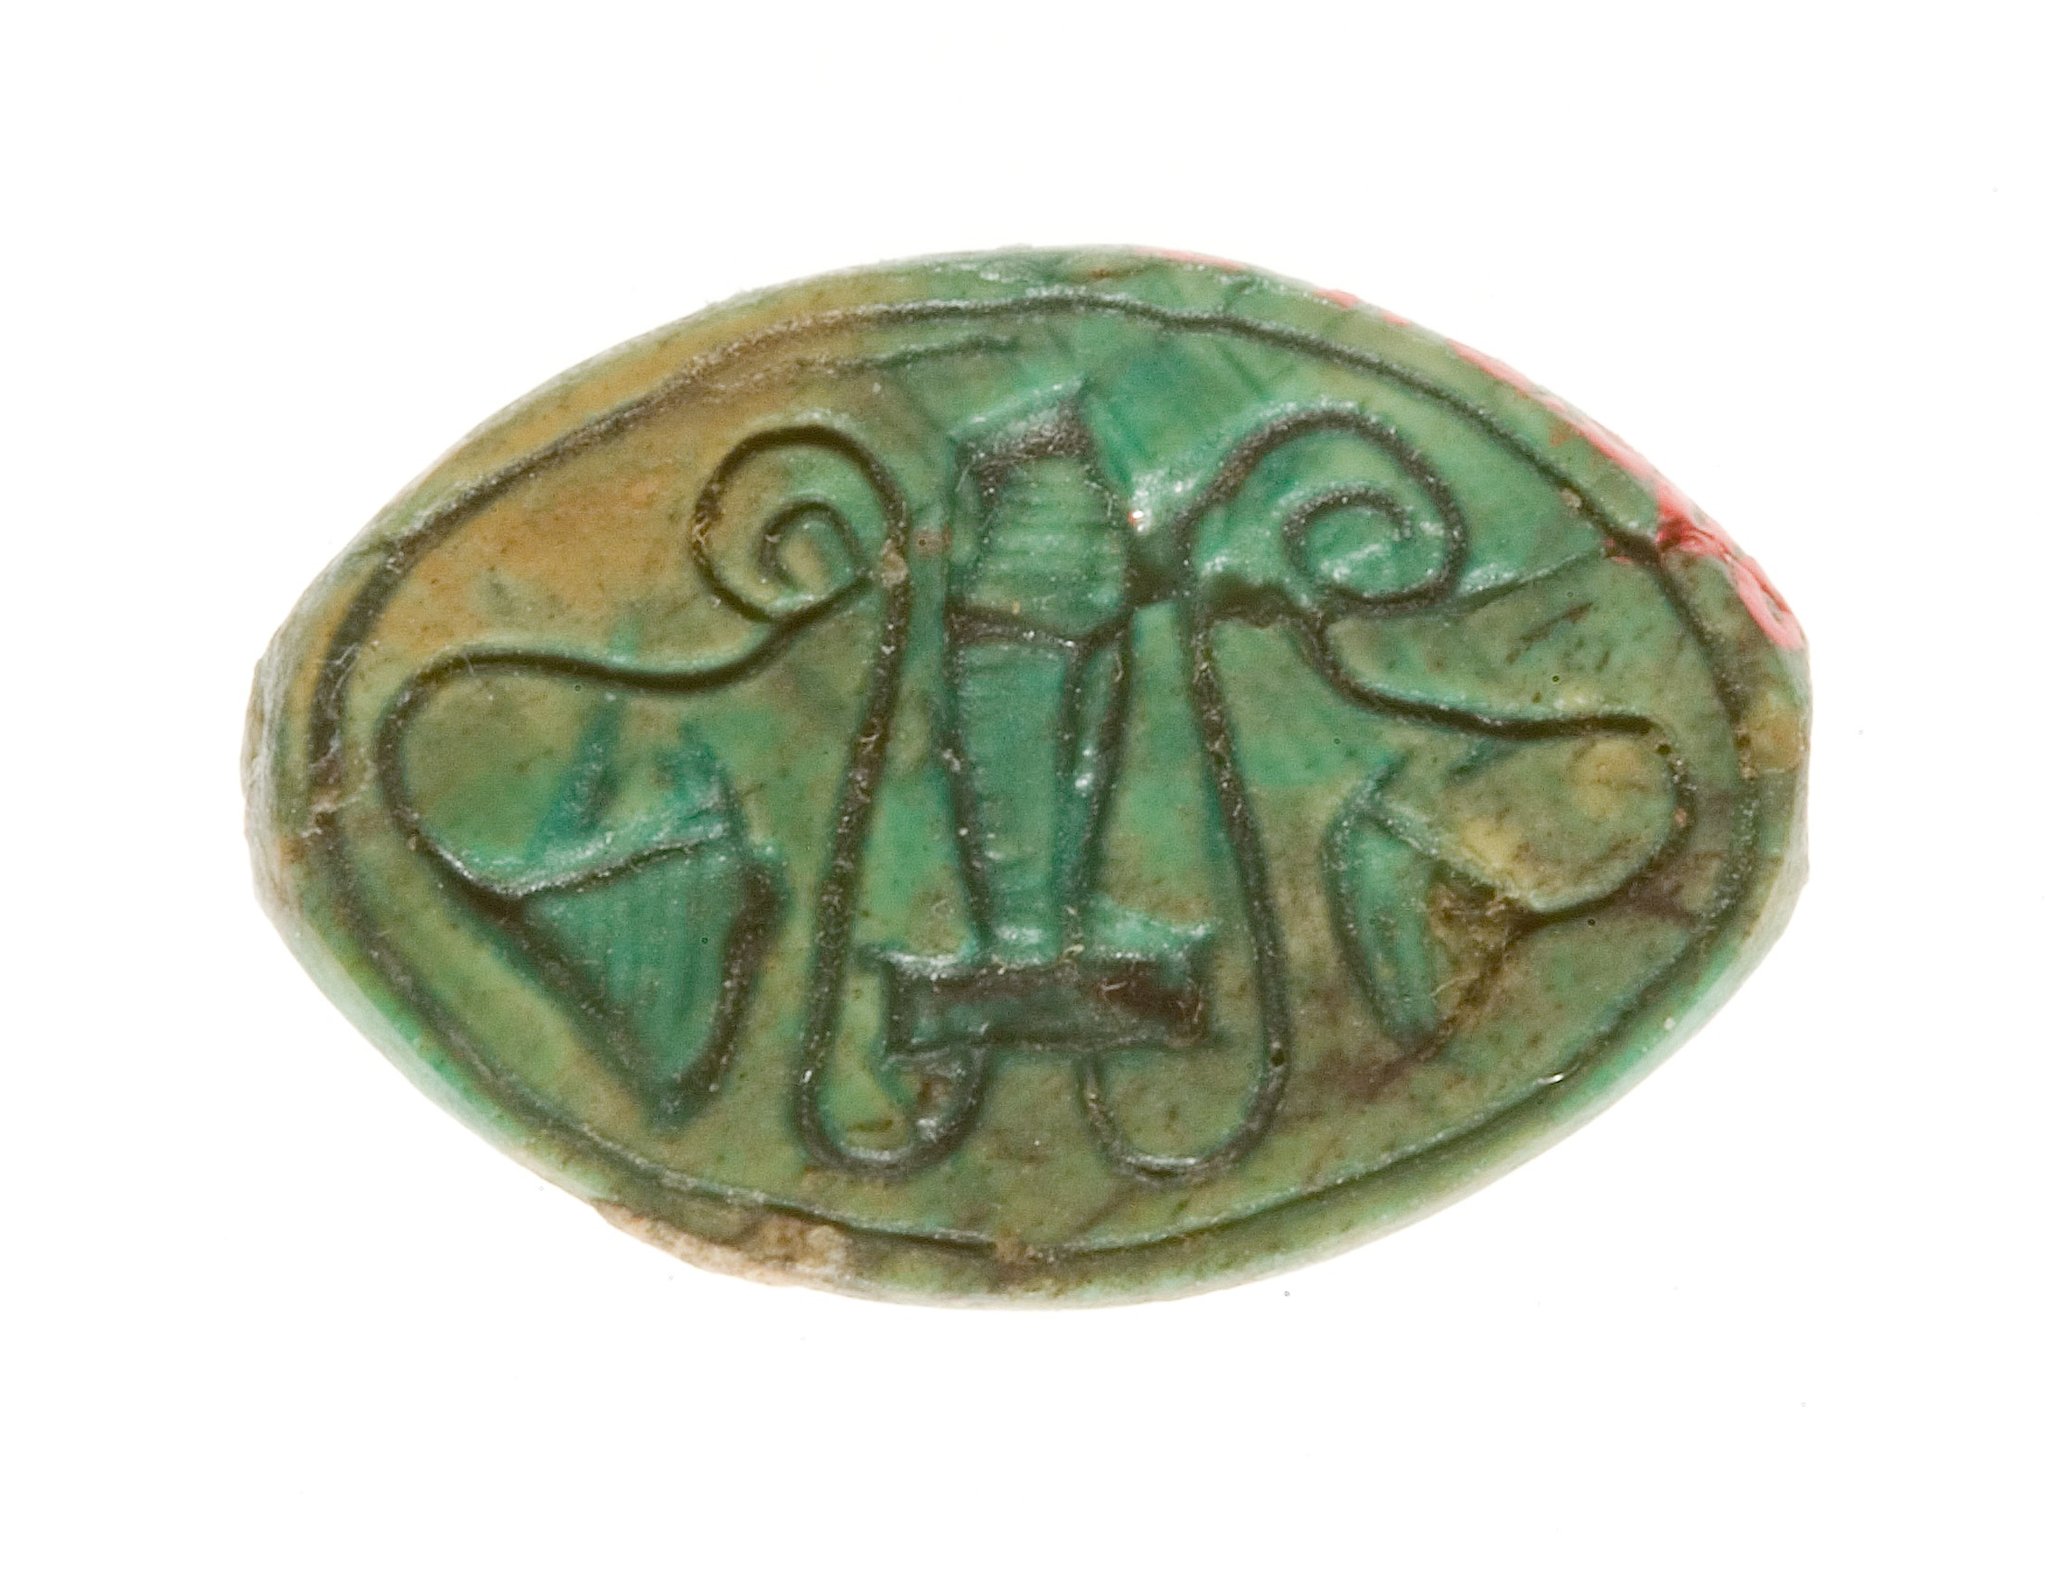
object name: cowroid, hatshepsut fd, papyrus lotus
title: Cowroid Seal Amulet Inscribed with a Plant Motif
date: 1479-1458 BCE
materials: stone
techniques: glazing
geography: egypt